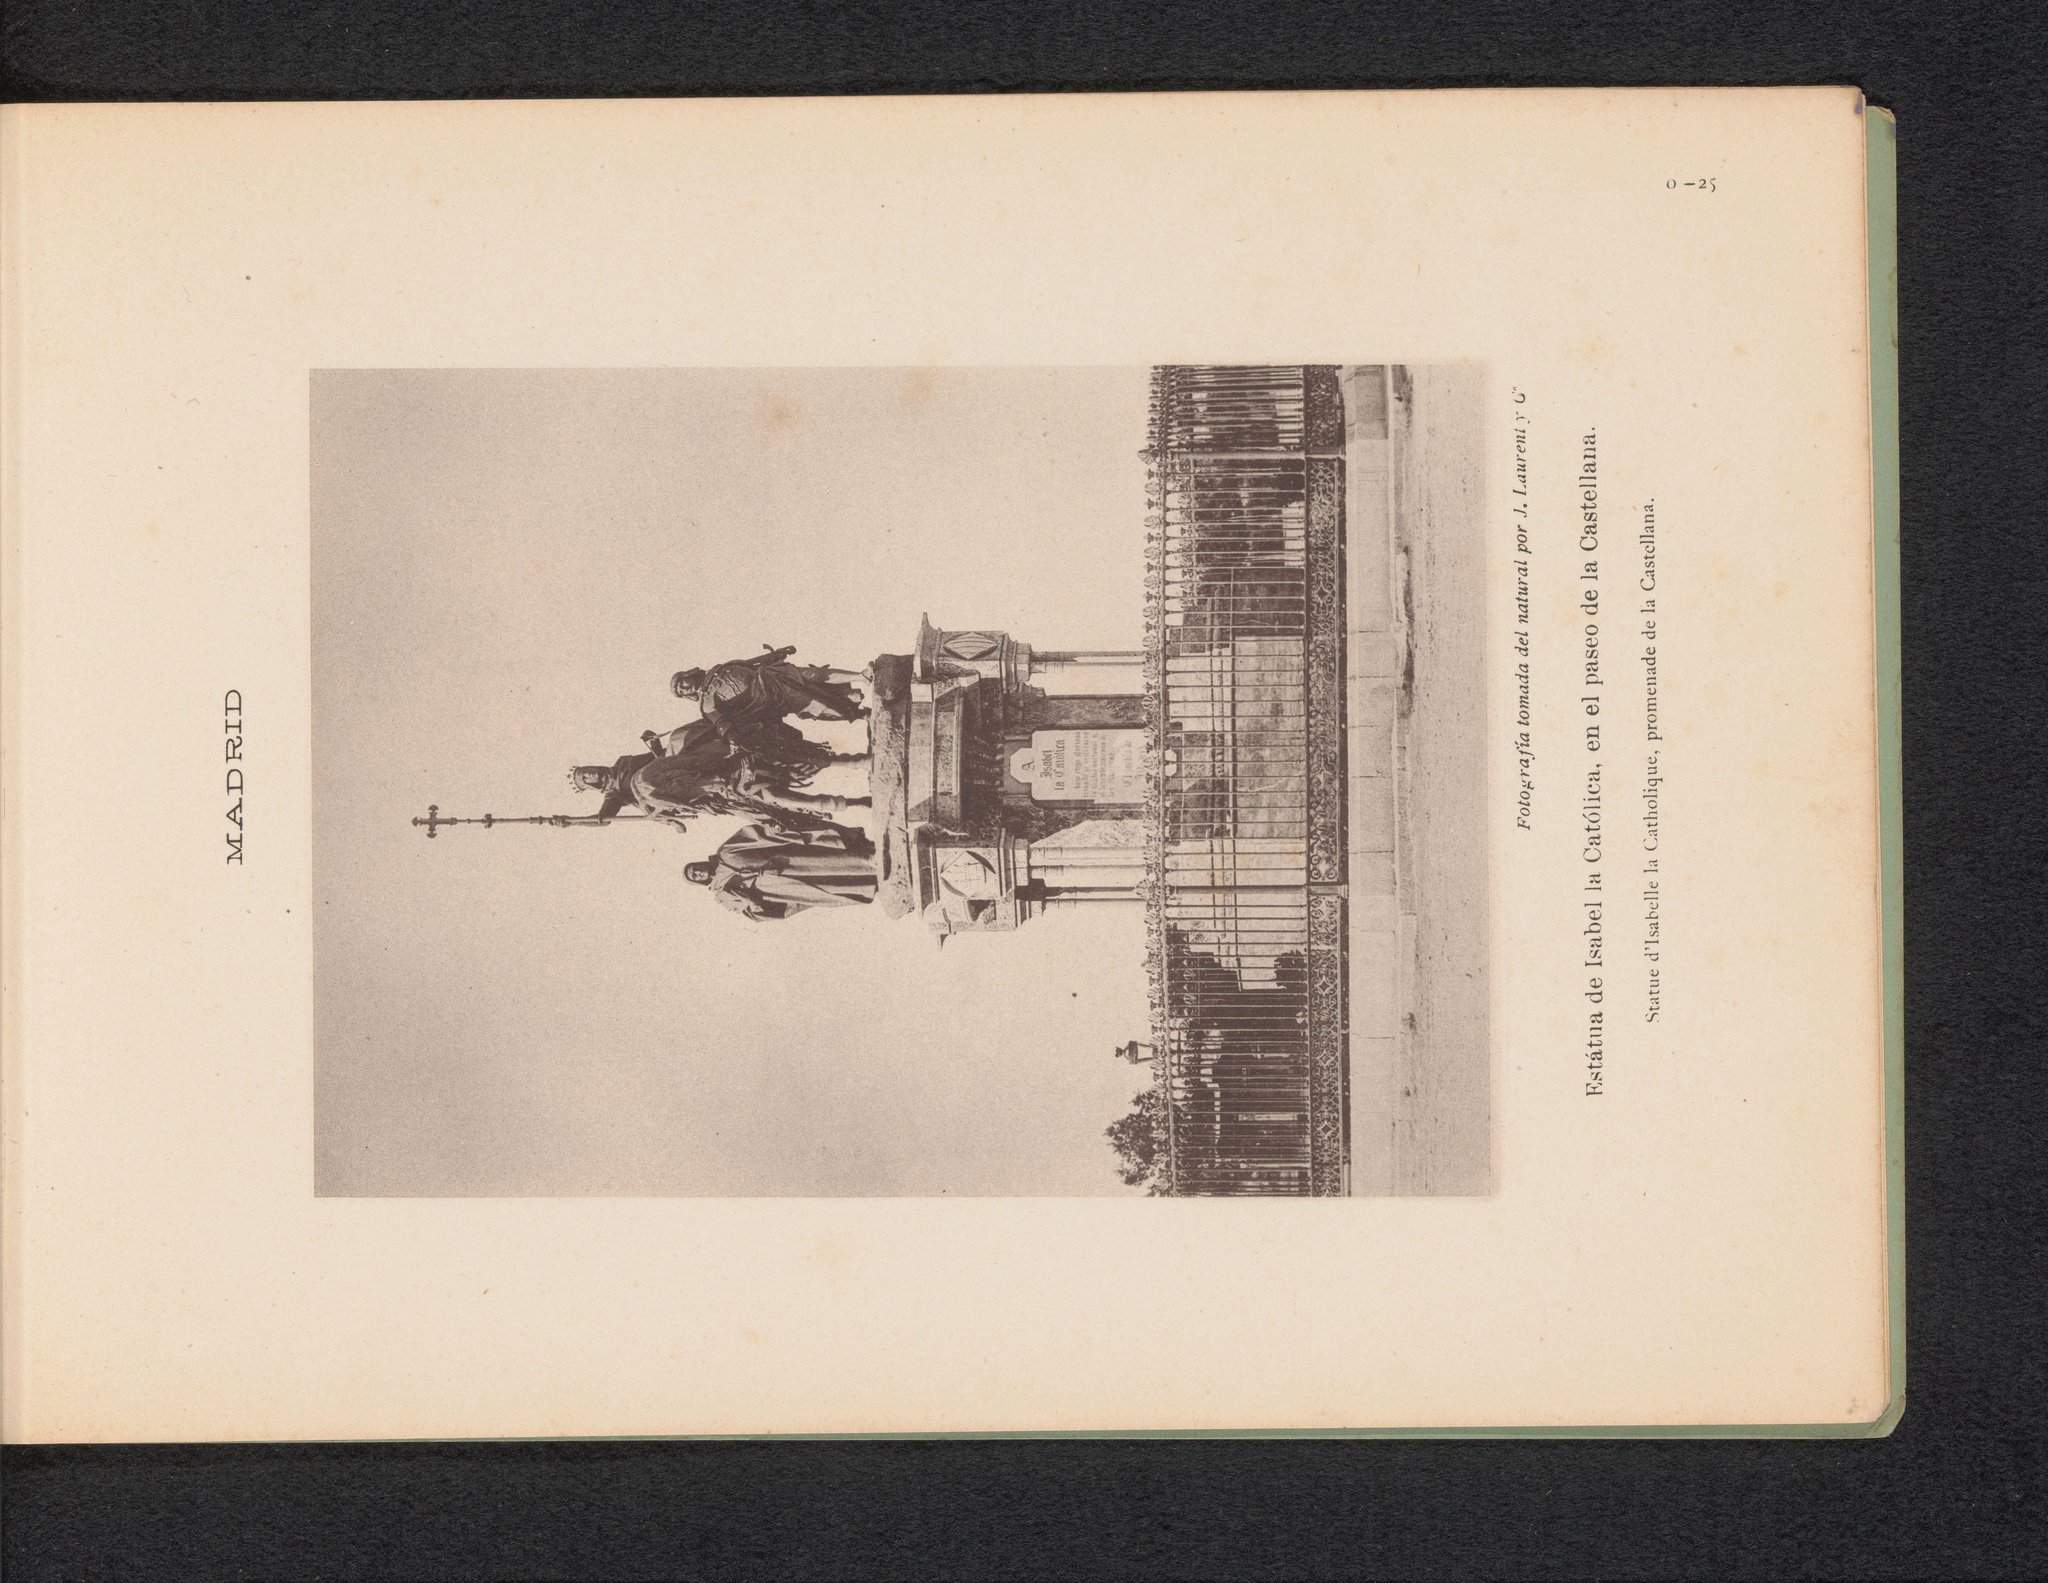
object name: photomechanical print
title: Estátua de Isabel la Católica, en el paseo de la Castellana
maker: juan laurent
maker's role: publisher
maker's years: 1816-1896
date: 1880-1890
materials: paper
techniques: photograph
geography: madrid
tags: monument, statue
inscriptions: number: ‘0-25’